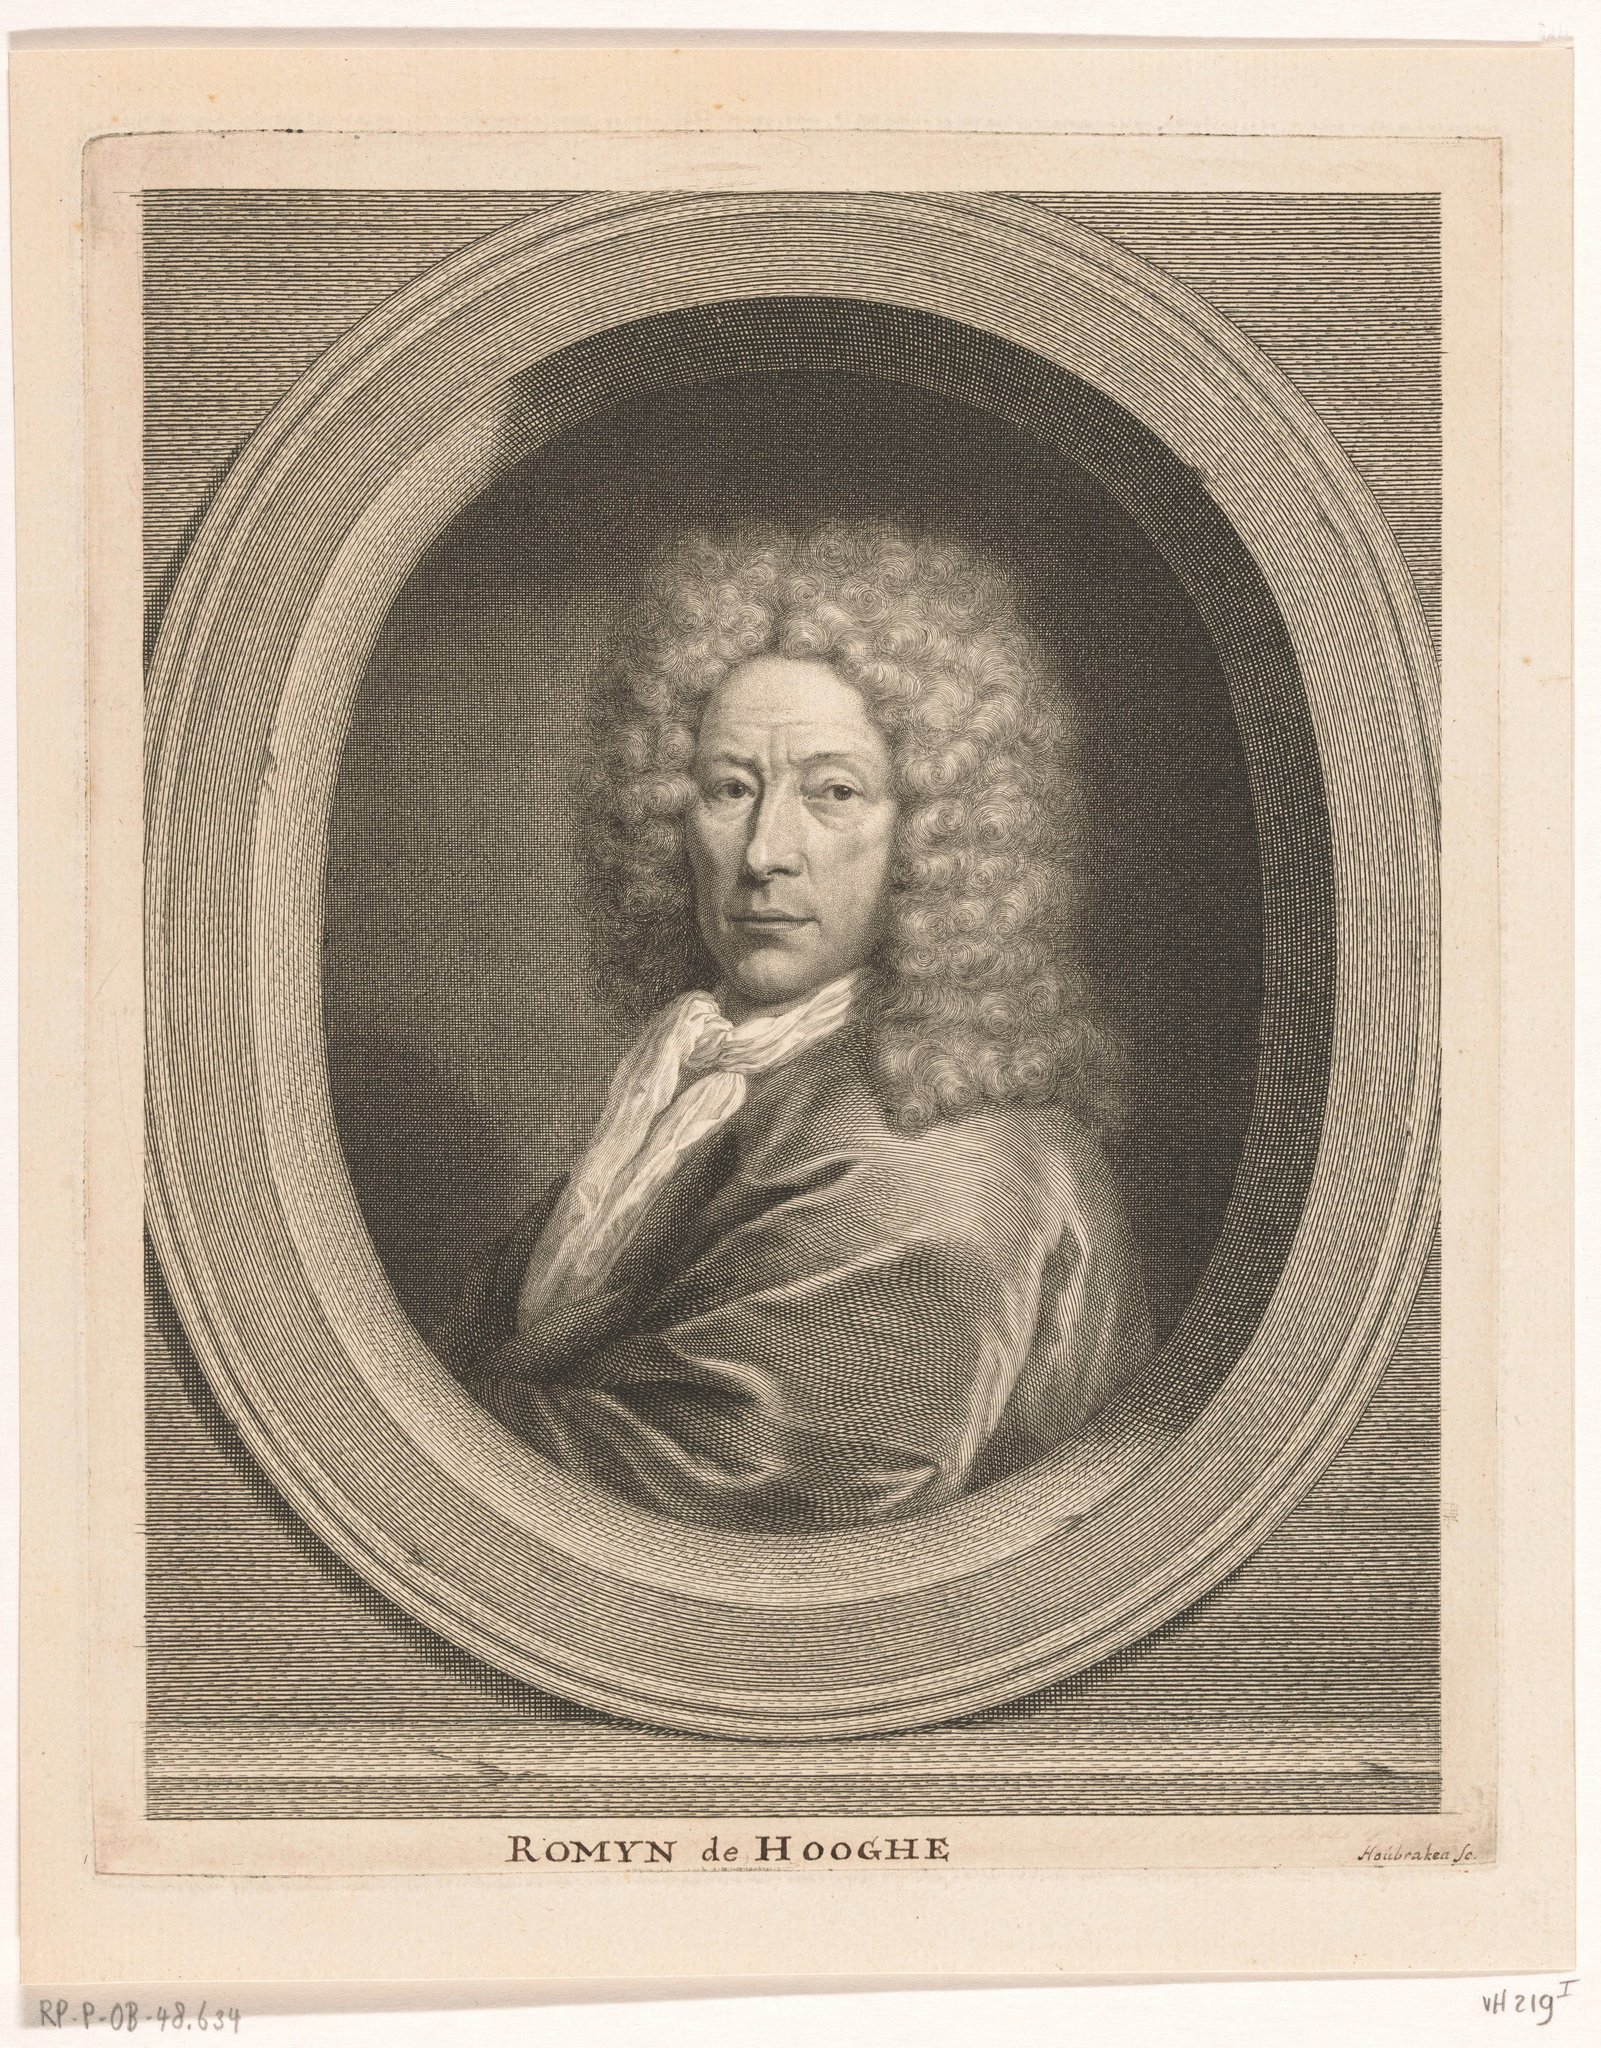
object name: print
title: Romyn de Hooghe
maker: jacob houbraken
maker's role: draughtsman, print maker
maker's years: 1698-1780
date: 1731-1733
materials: paper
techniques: engraving, pen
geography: amsterdam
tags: amsterdam, painter, print maker, draughtsman, goldsmith, romeyn de hooghe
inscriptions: inscription: ‘Romyn de Hooghe’, collector's mark: Lugt 240, inscription: ‘Houbraken fc.’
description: Buste naar links van Romeyn de Hooghe in een ovale archtectonische omlijsting. De titel is handgeschreven.